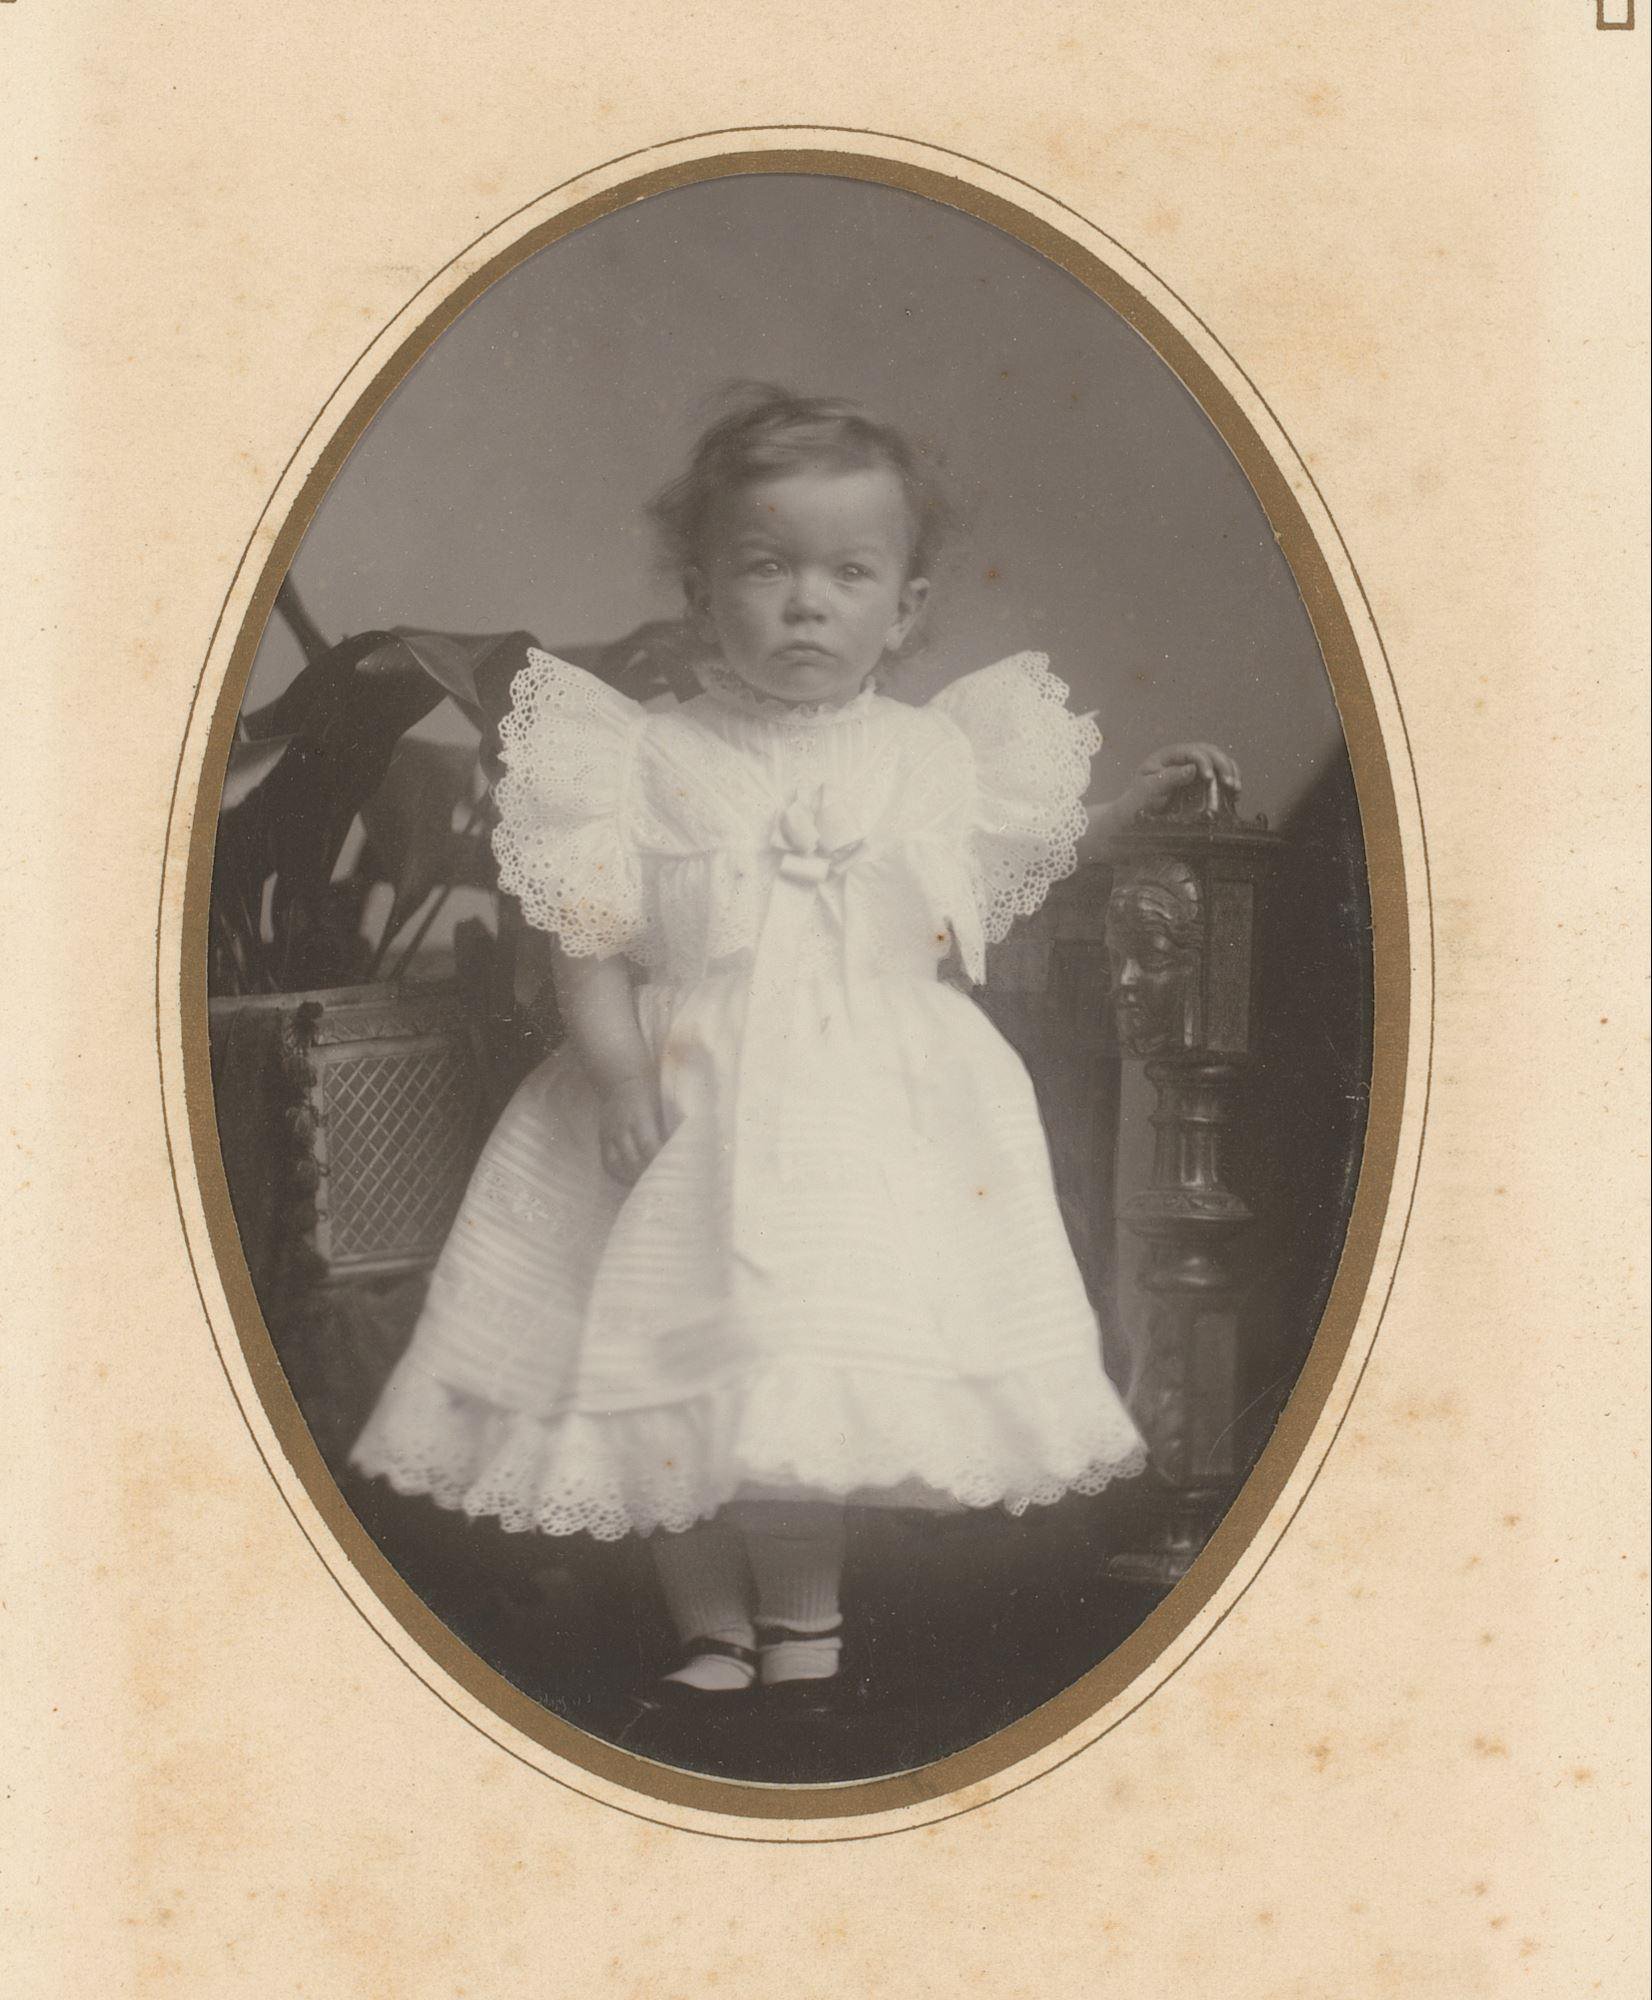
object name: photograph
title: Portret van een meisje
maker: johannes baer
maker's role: fotograaf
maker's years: 1840-1912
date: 1892-1906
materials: cardboard, photographic support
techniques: collodion silver print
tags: historical persons, girl (child between toddler and youth)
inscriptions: inscription: ‘J. Baer Rotterdam/ Diergaardelaan No. 44’